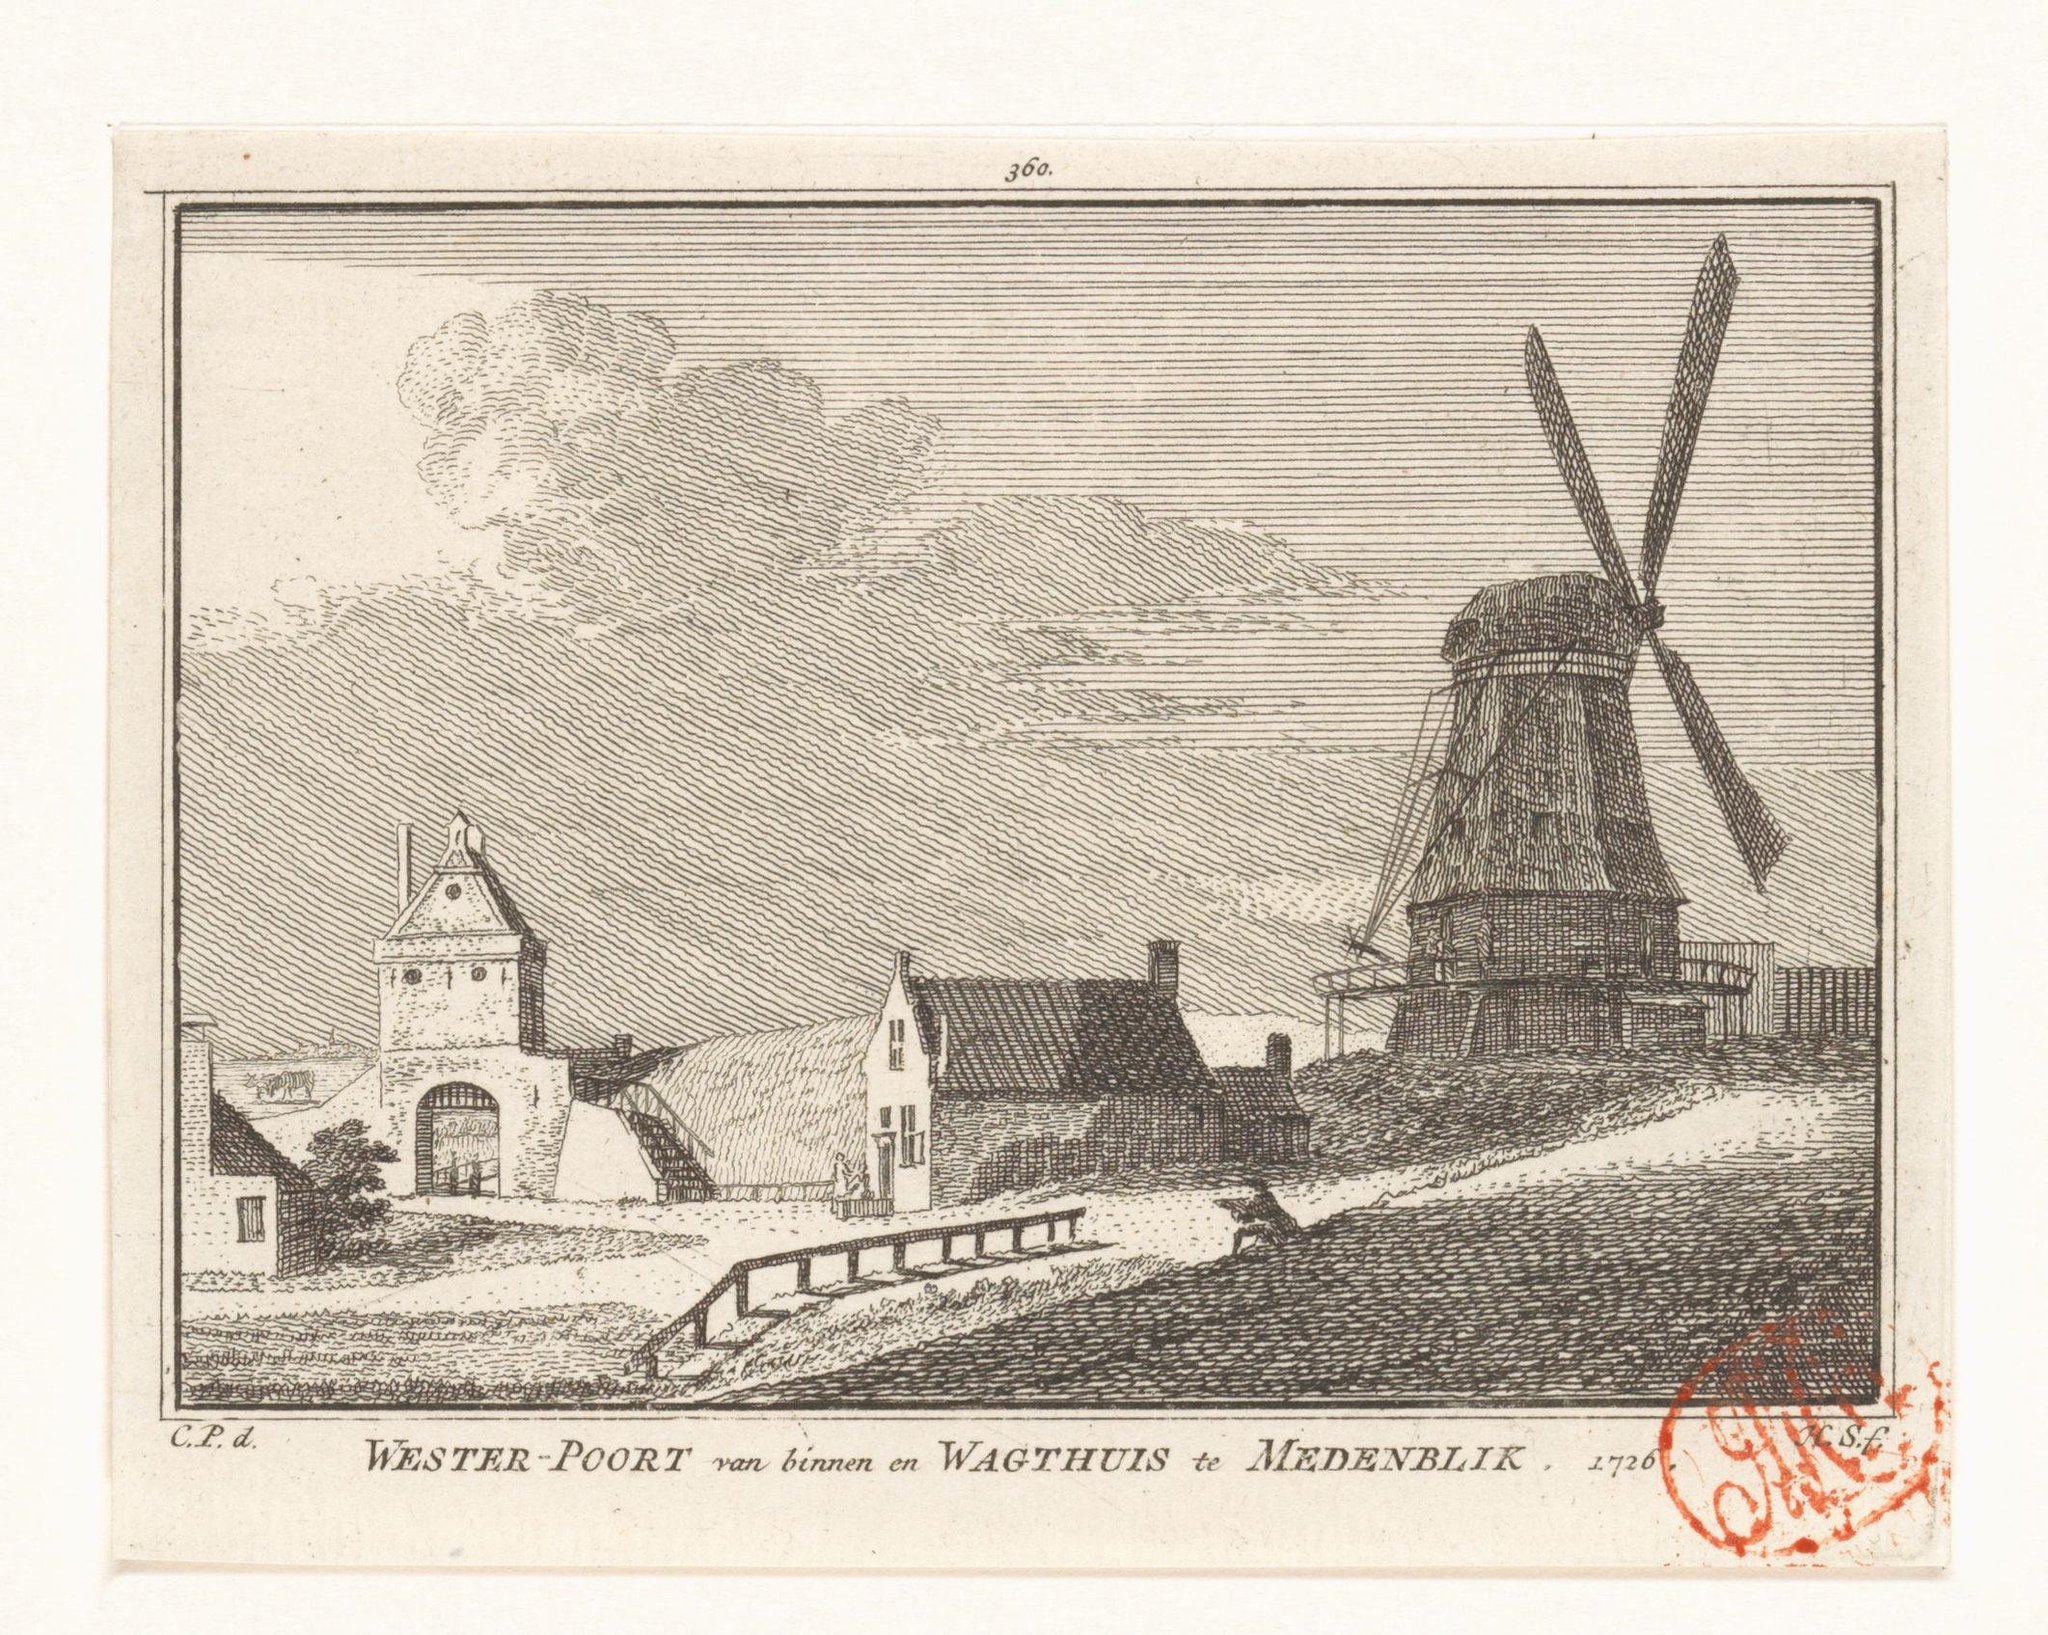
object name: book illustration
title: Wester-poort van binnen en wagthuis te Medenblik. 1726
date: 1752-1792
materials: paper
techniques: engraving, etching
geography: haarlem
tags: windmill, city-gate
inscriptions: collector's mark: Lugt 195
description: Prent ook gebruikt in: Het verheerlykt Nederland of kabinet van hedendaagsche gezigten van steden, dorpen (…). 9 delen. Amsterdam: Isaak Tirion en weduwe Isaak Tirion, 1745-1774, dl. 4 (1752), ill. 360. Of in: Nederlandsche tafereelen; of eene keurige verzameling van negen honderd fraaije gezigten van steden, dorpen, sloten, oudheden (….). 9 delen. Amsterdam: Jan de Groot, 1792, dl. 4, ill. 360. Uit welke druk het huidige exemplaar precies komt is niet na te gaan.